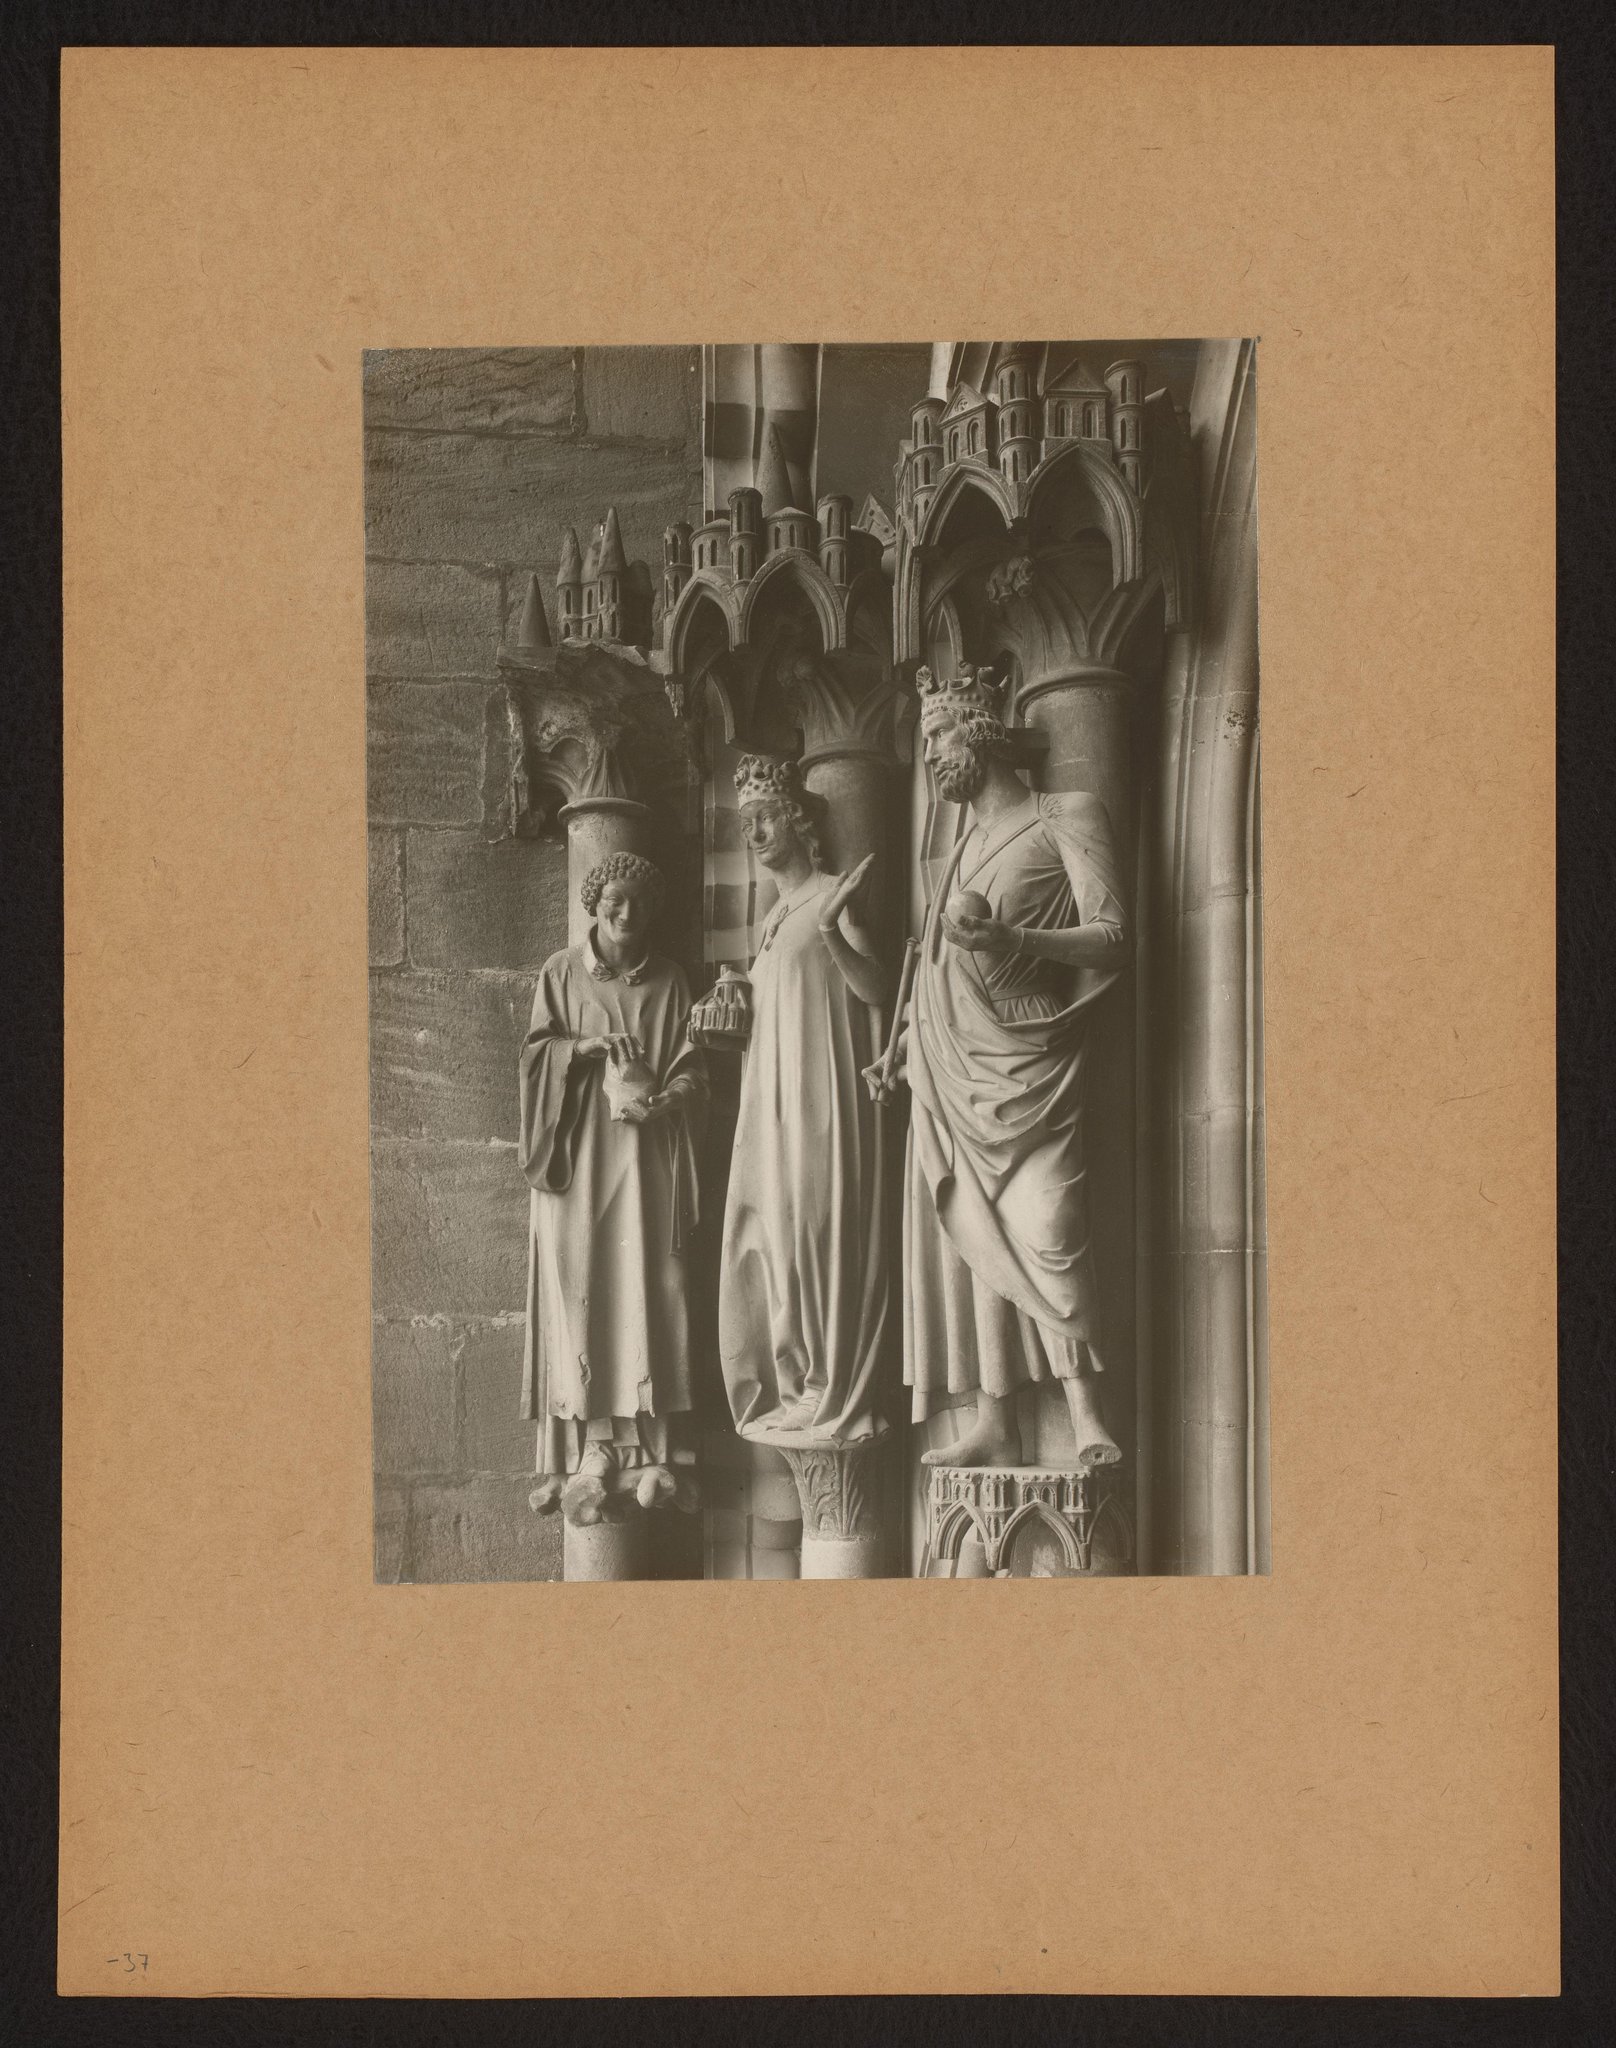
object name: album leaf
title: Detail van de Adamspforte in de dom van Bamberg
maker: Anonymous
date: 1900-1920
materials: paper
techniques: gelatin silver print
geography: bamberg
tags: church (exterior)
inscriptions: number: ‘37.’